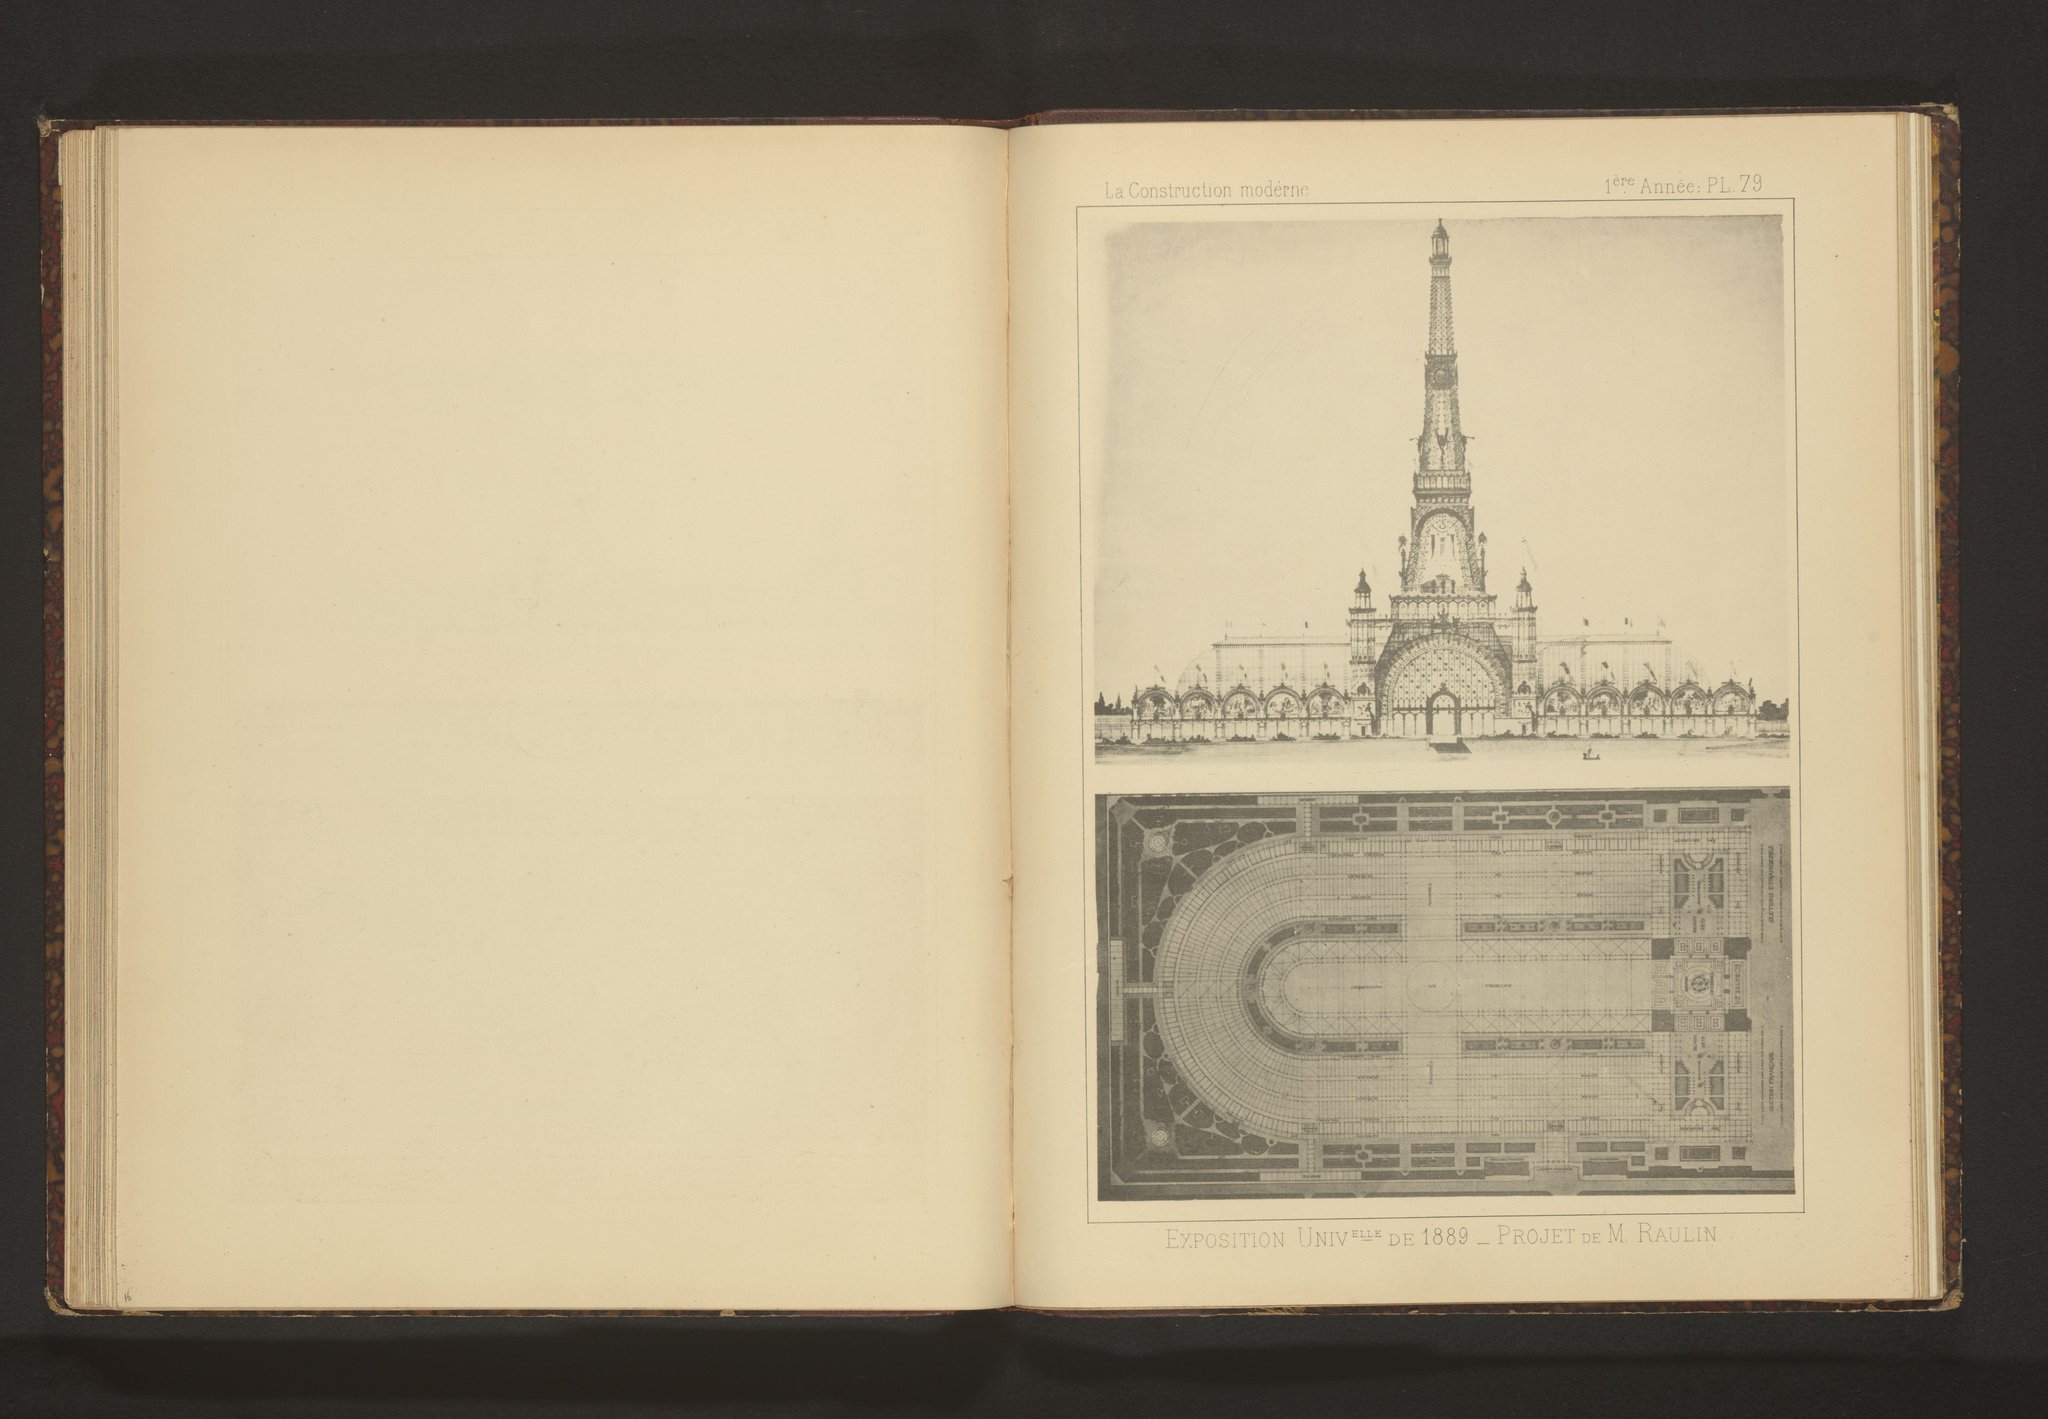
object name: photomechanical print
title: Exposition Univelle de 1889, Projet de M. Raulin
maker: Anonymous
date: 1881-1886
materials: paper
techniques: photograph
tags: world fair, world exhibition, maps of cities, eiffel tower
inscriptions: inscription: ‘1ère Année: LA CONSTRUCTION MODERNE Pl. 79’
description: Boven een gezicht op de wereldtentoonstelling, onder een plattegrond van de wereldtentoonstelling.